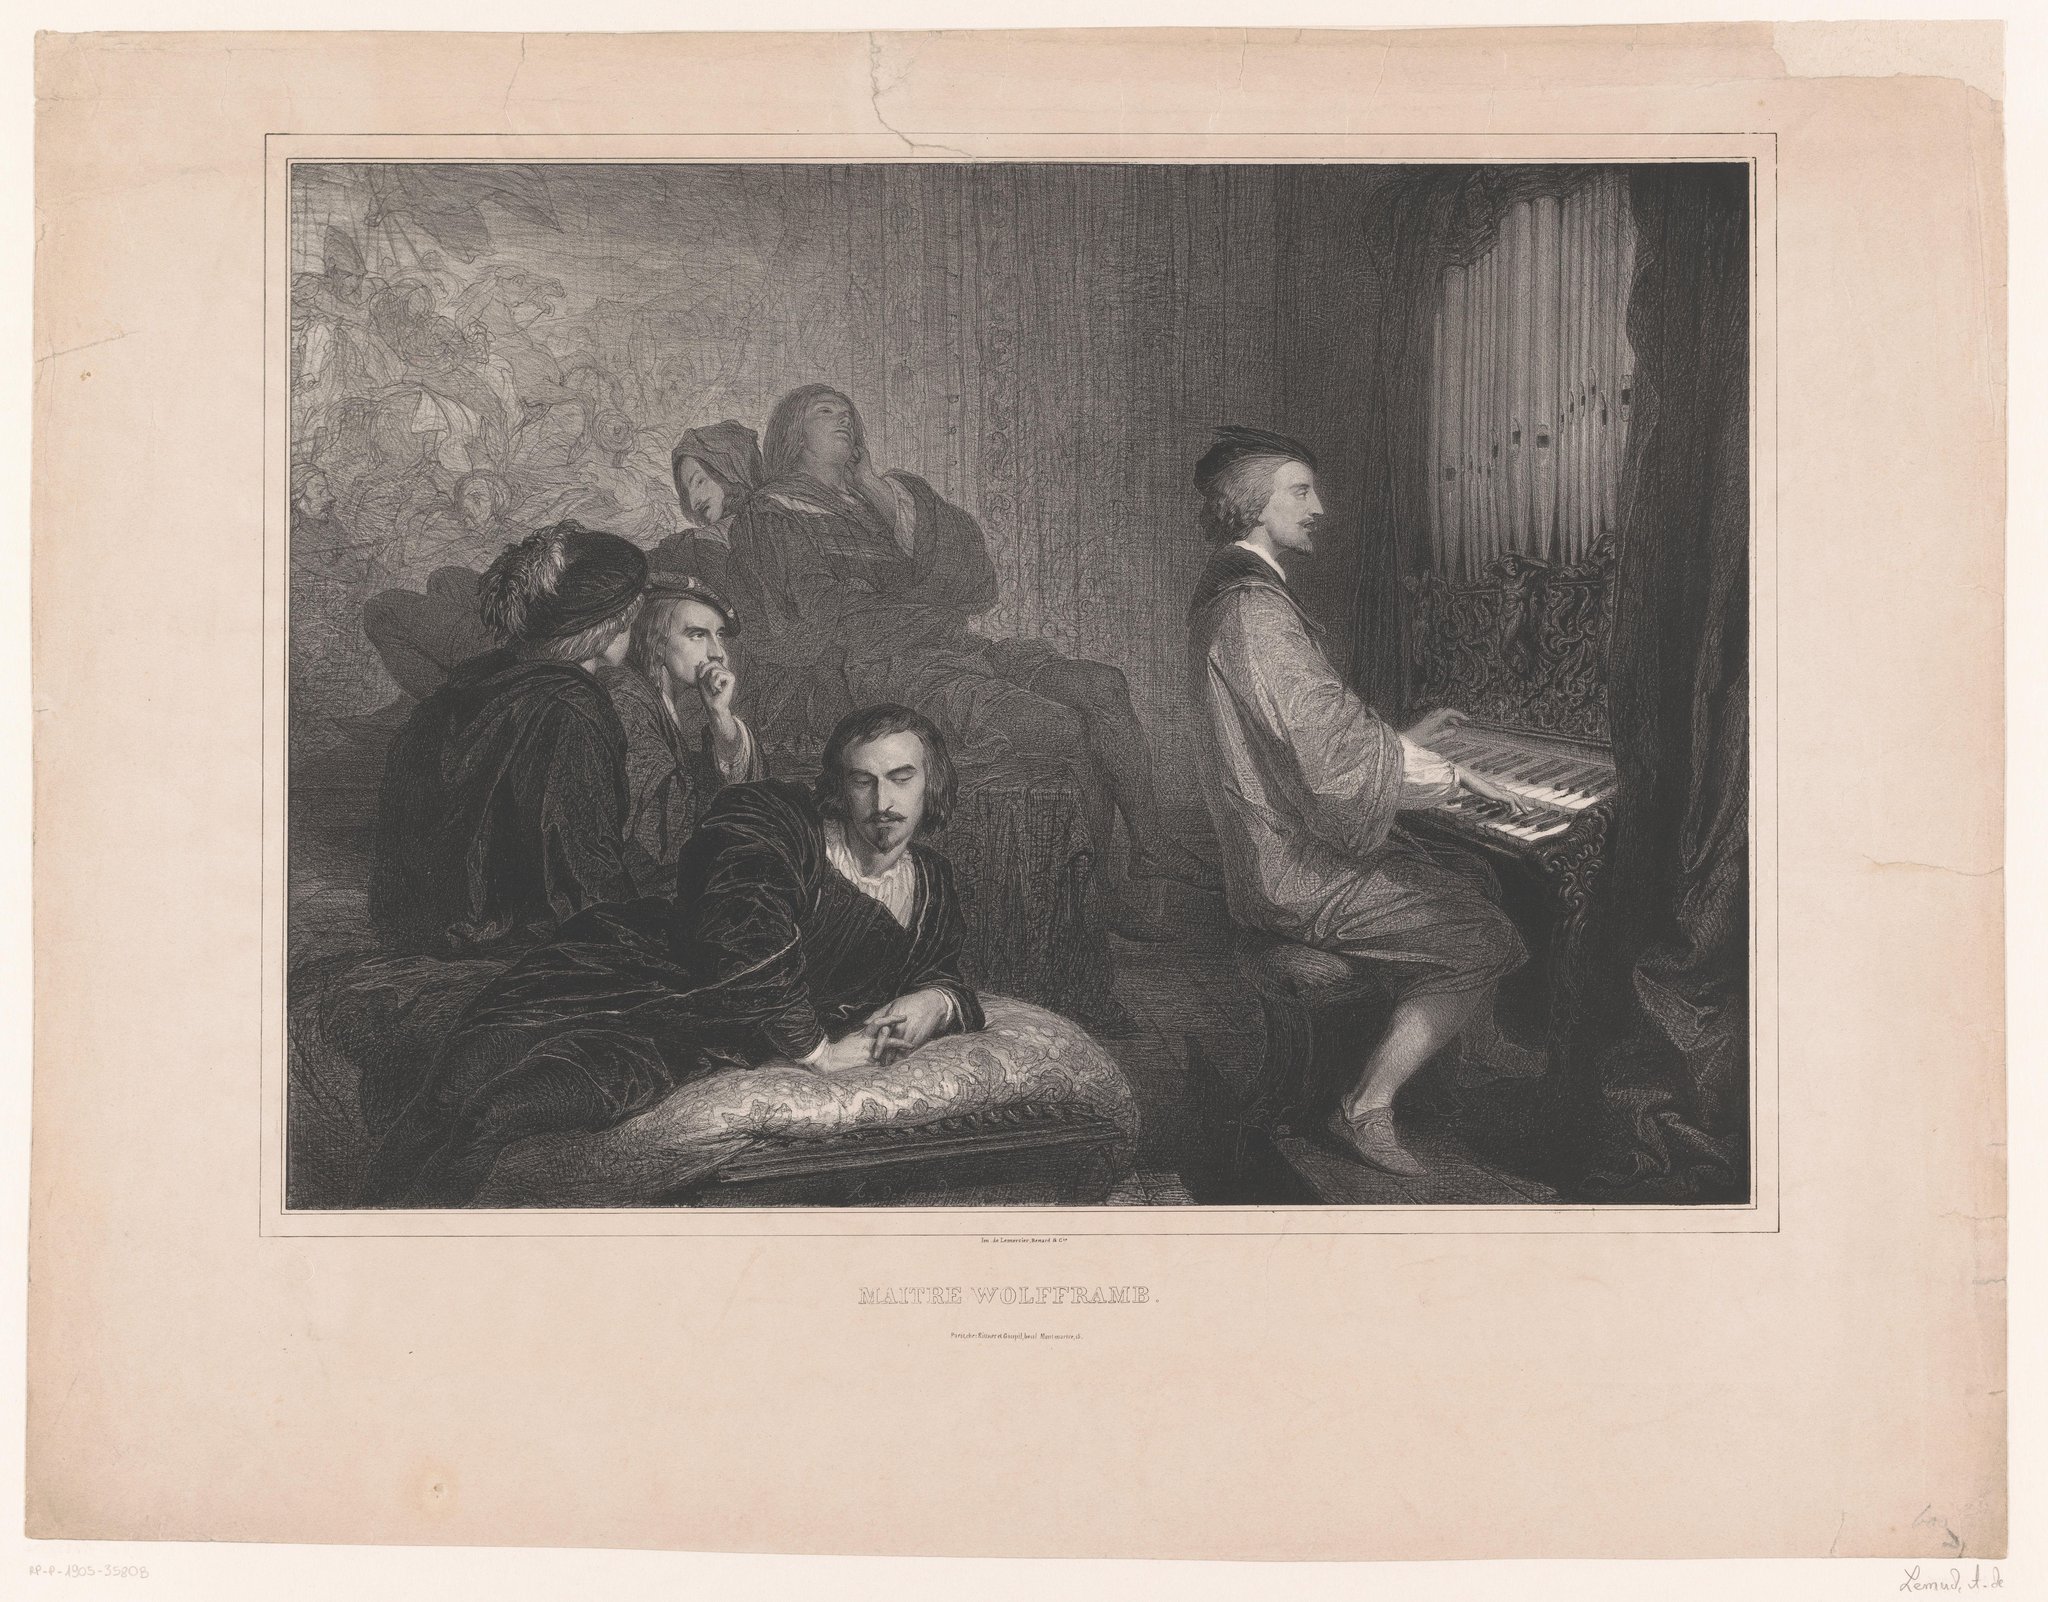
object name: print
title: Wolfram von Eschenbach zingt en bespeelt een orgel voor vijf mannen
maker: aimé de lemud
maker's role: print maker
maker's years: 1816-1887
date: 1838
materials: paper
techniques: lithograph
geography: paris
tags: musician, listening to music, organ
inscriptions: check stamp: Lugt 2140, collector's mark: Lugt 2228